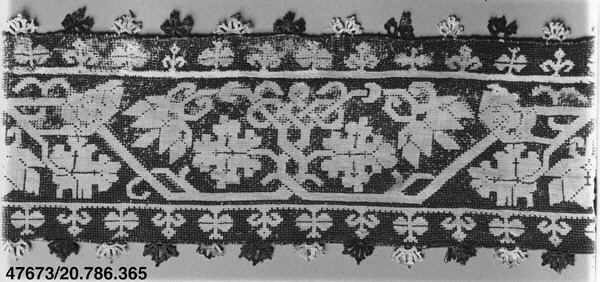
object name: border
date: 1501-1600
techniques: embroidery